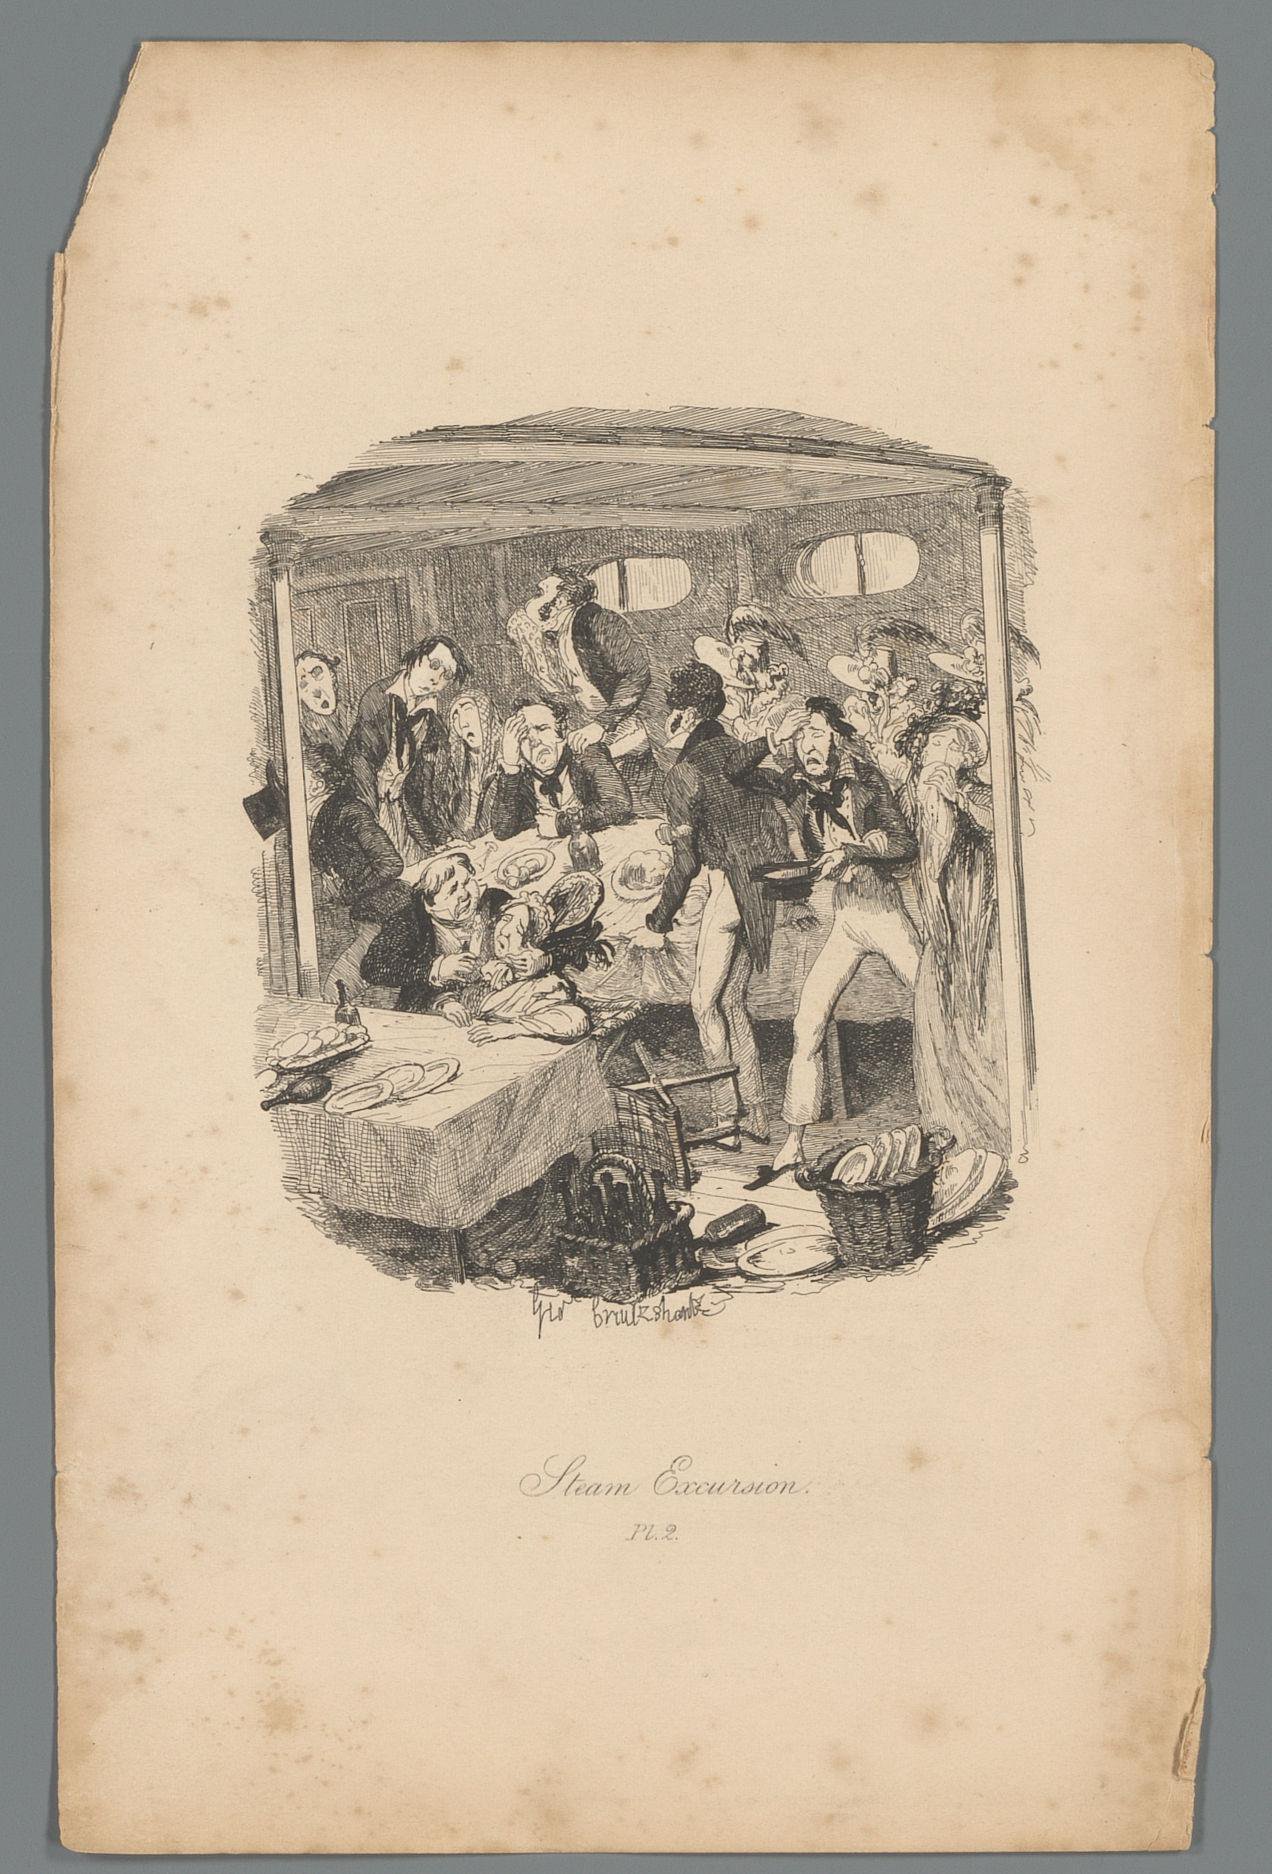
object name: print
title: Passagiers worden zeeziek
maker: george cruikshank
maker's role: painter, print maker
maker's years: 1792-1878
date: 1836-1839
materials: paper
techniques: etching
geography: england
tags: sea-sickness, steamship, motorship (+ propulsion of vehicle, ship, etc. by steam), political caricatures and satires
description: De passagiers in de eetzaal aan boord van een stoomboot worden zeeziek. Illustratie voor een uitgave van Sketches by 'Boz' van Charles Dickens, 1836-1839.